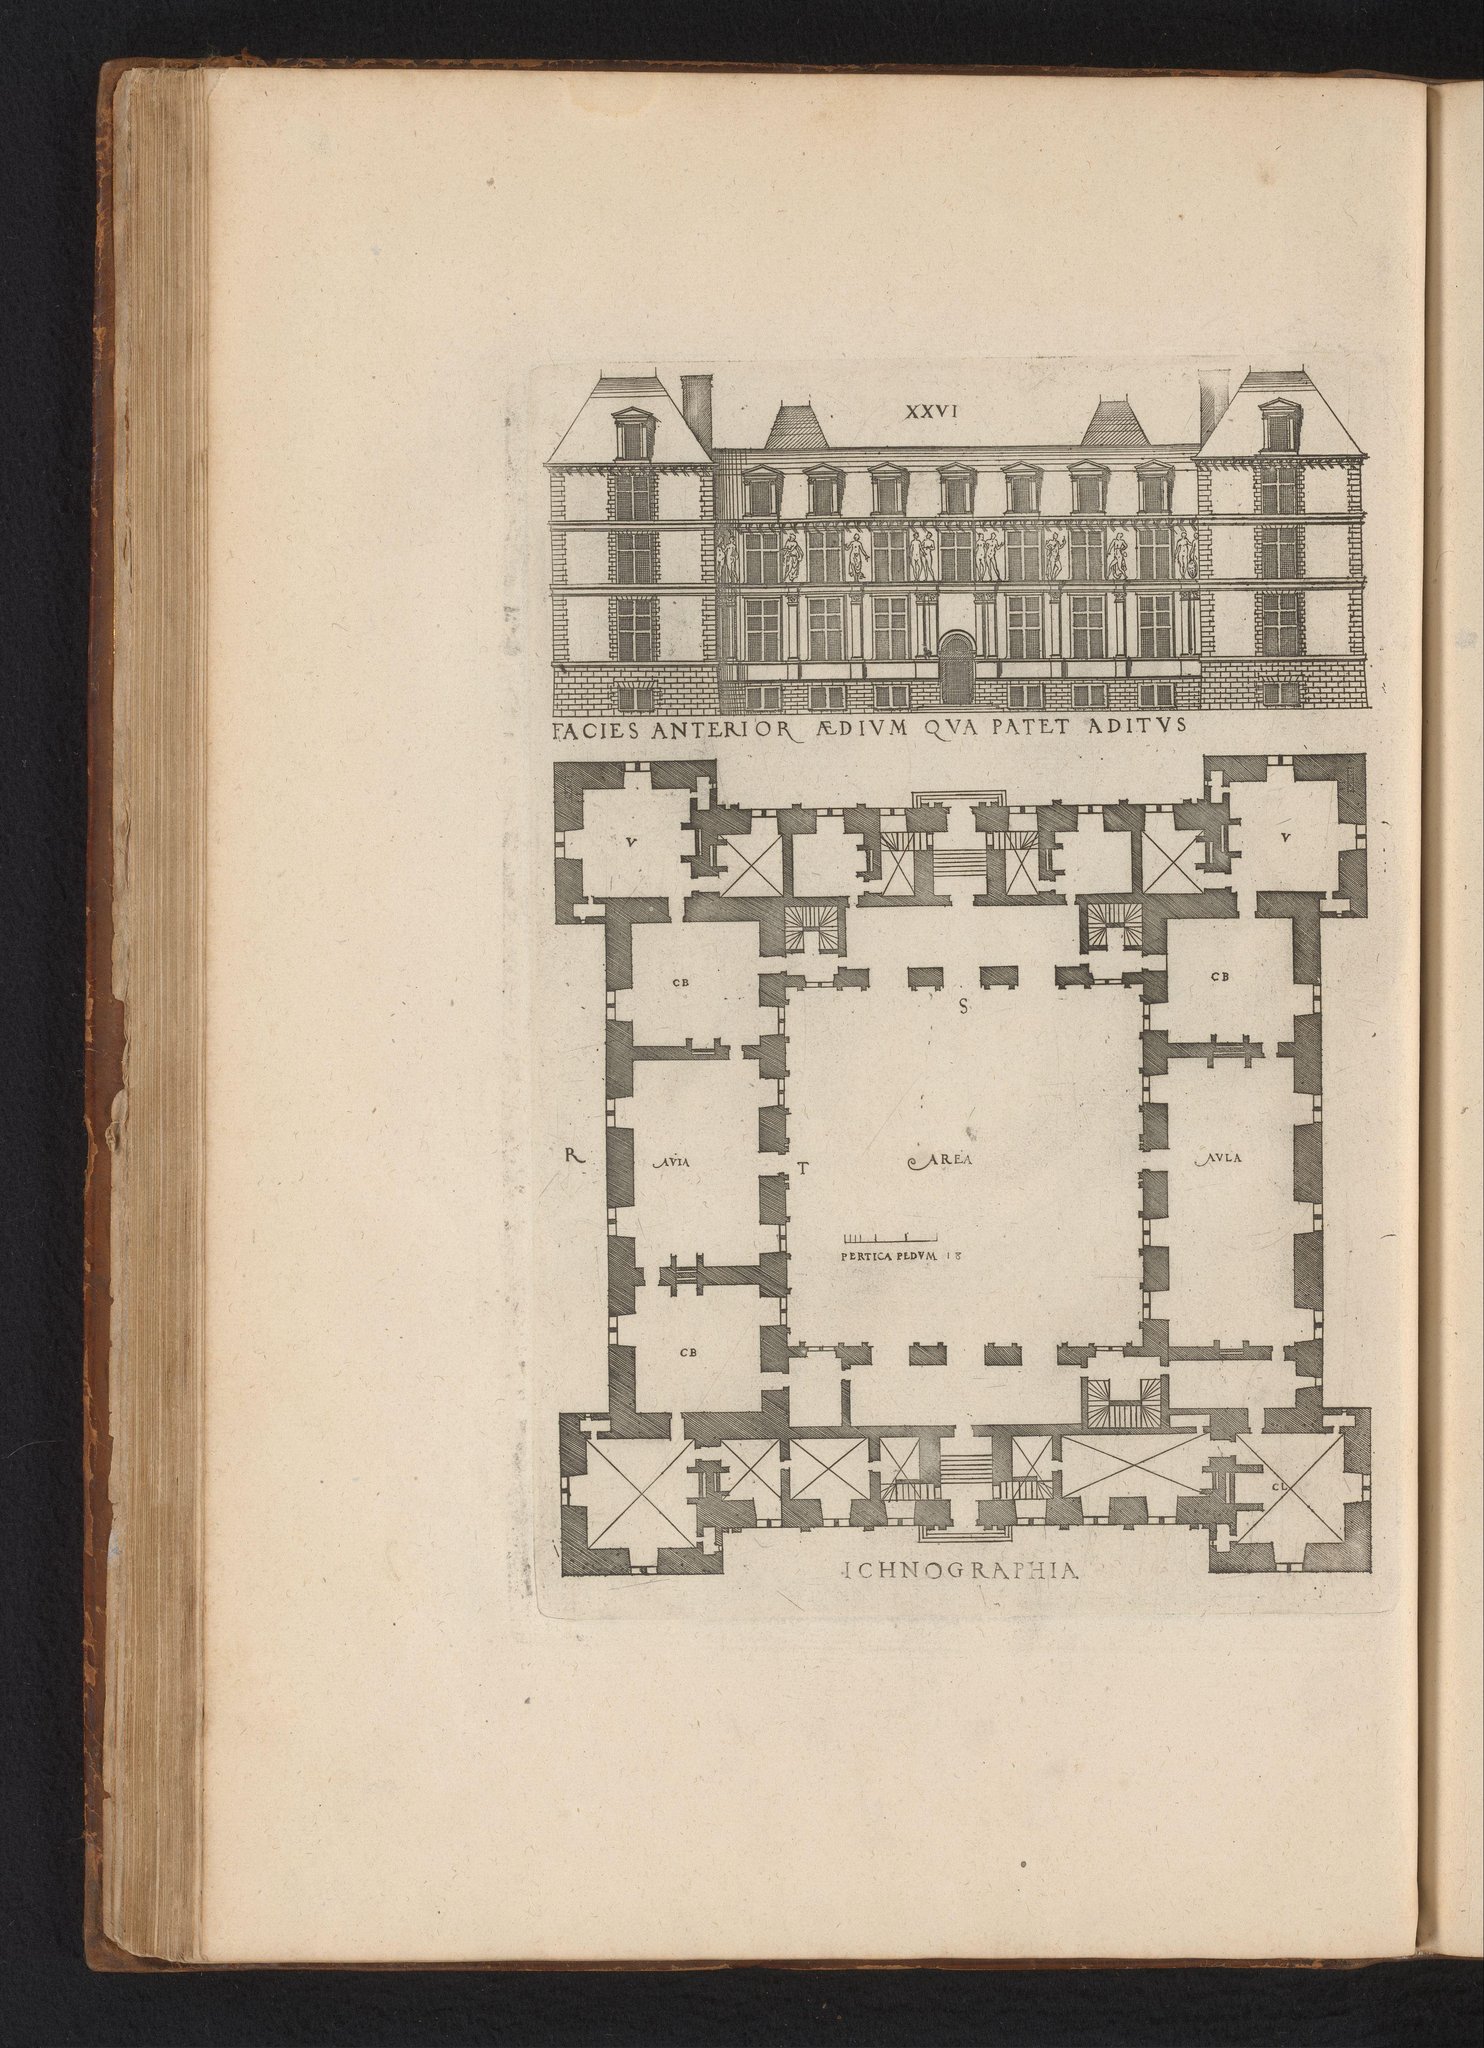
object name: ornament print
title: Voorgevel en plattegrond van het Château d'Ancy-le-Franc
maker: jacques androuet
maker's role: draughtsman, print maker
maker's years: 1515-1584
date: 1559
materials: paper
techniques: etching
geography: paris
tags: façade (of house or building), plan ~ architecture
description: Voorgevel en plattegrond van het Château d'Ancy-le-Franc. Aanzicht en plattegrond van architectuur. Genummerd: XXVI. Onderdeel van 'De architectura Iacobi Androuetii du Cerceau' (1559): 69 etsen met 171 voorstellingen van architectuur en ornamentiek.